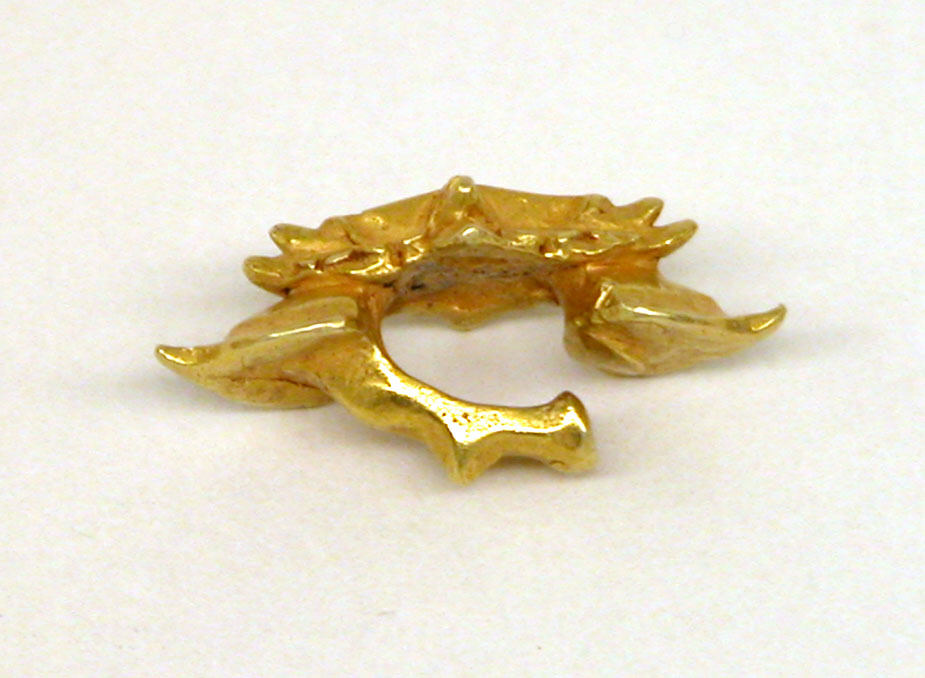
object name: ear ornament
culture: indonesian, javanese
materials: gold